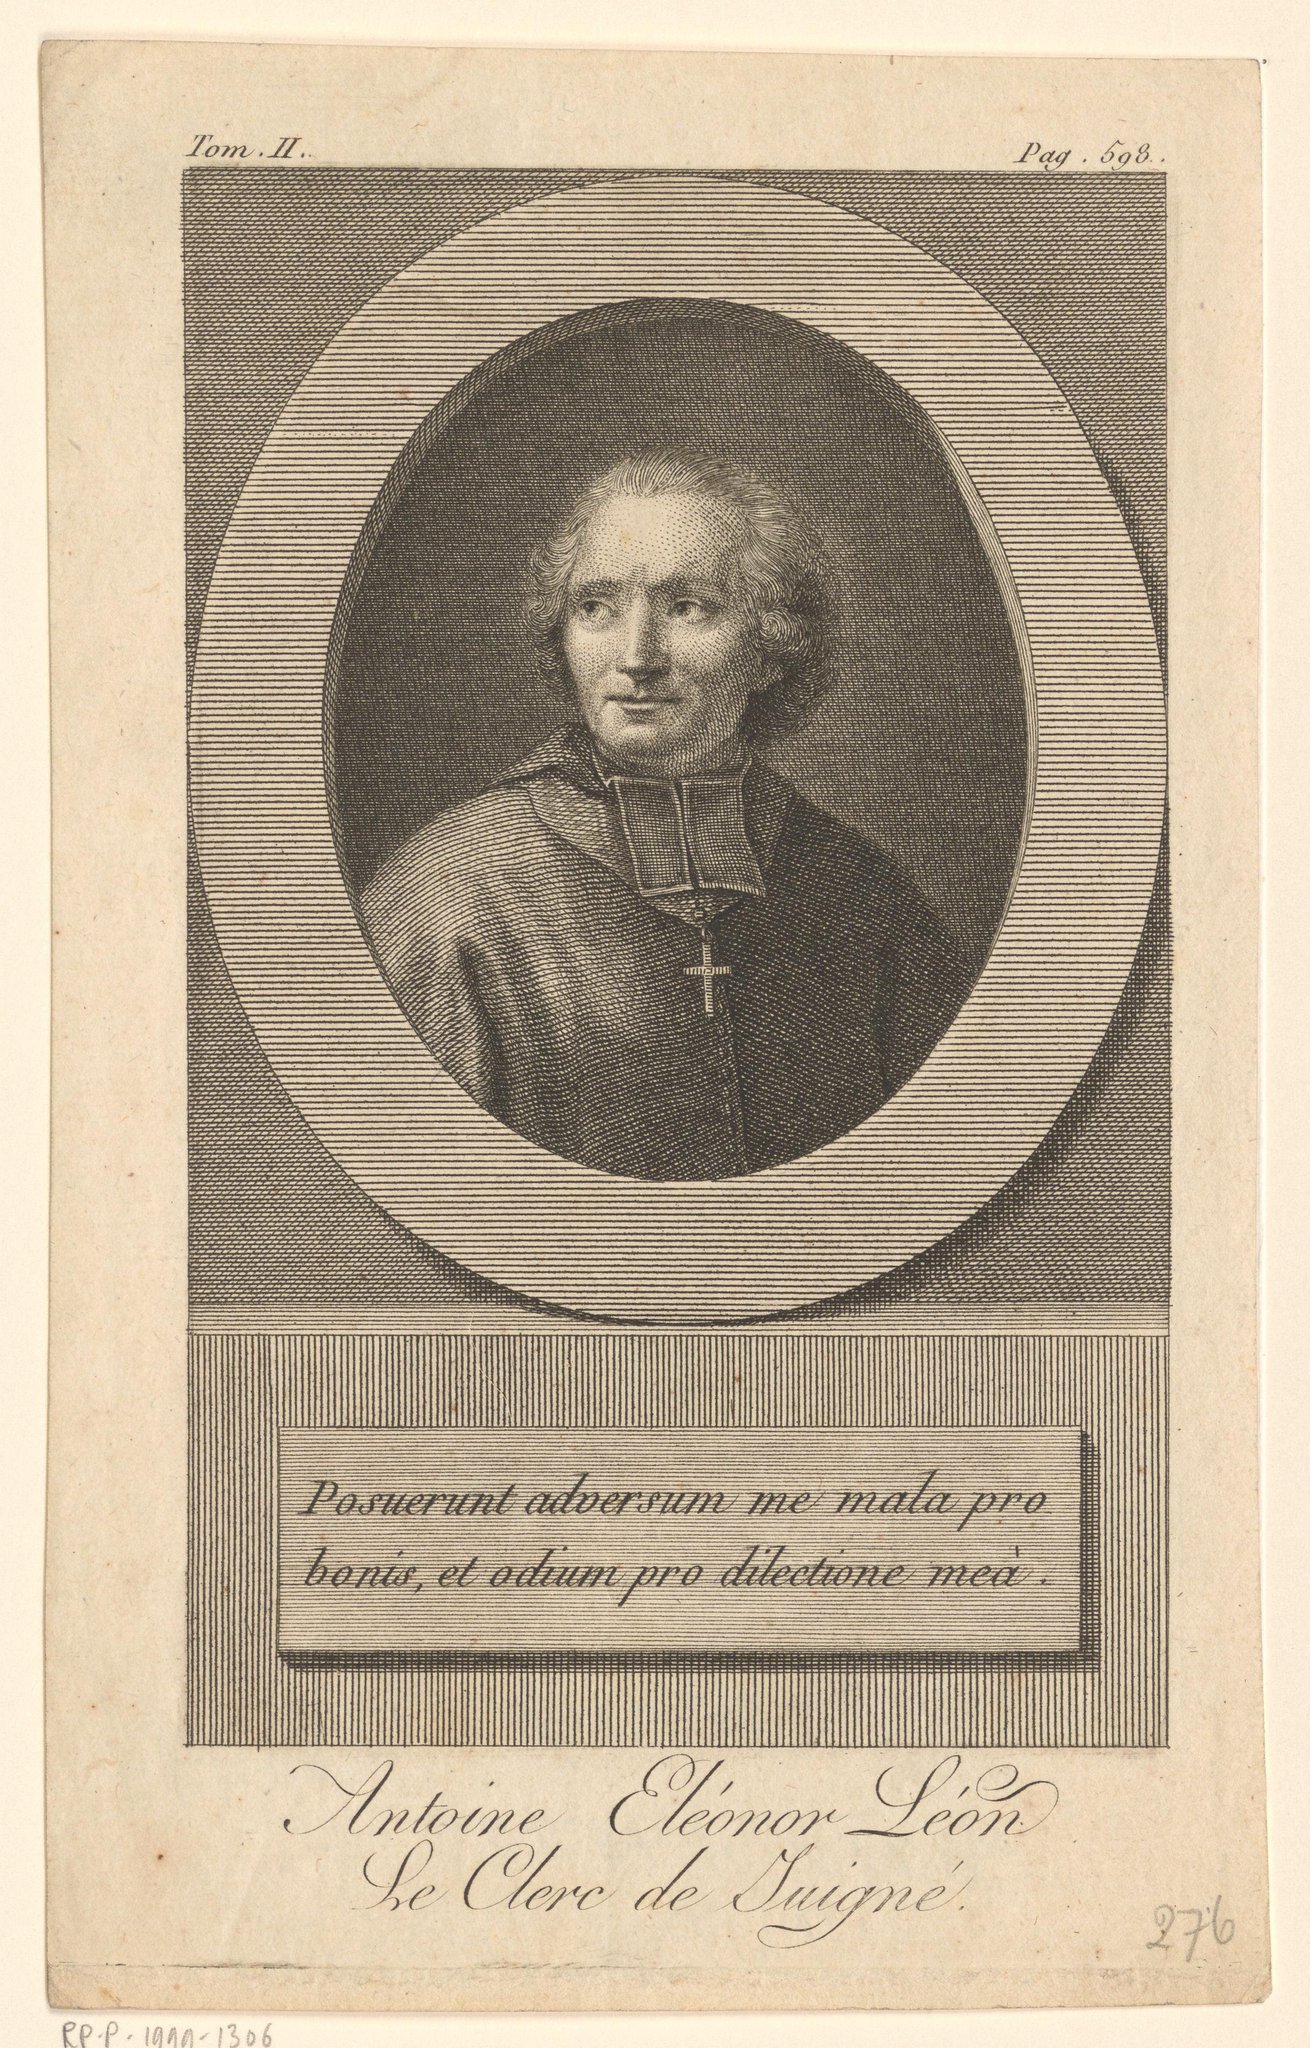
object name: print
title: Portret van Antoine Éléonor Léon Leclerc de Juigné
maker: Anonymous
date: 1753-1821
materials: paper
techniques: engraving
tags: paris, historical persons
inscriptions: collector's mark: Lugt 2760, collector's mark: Lugt 2282